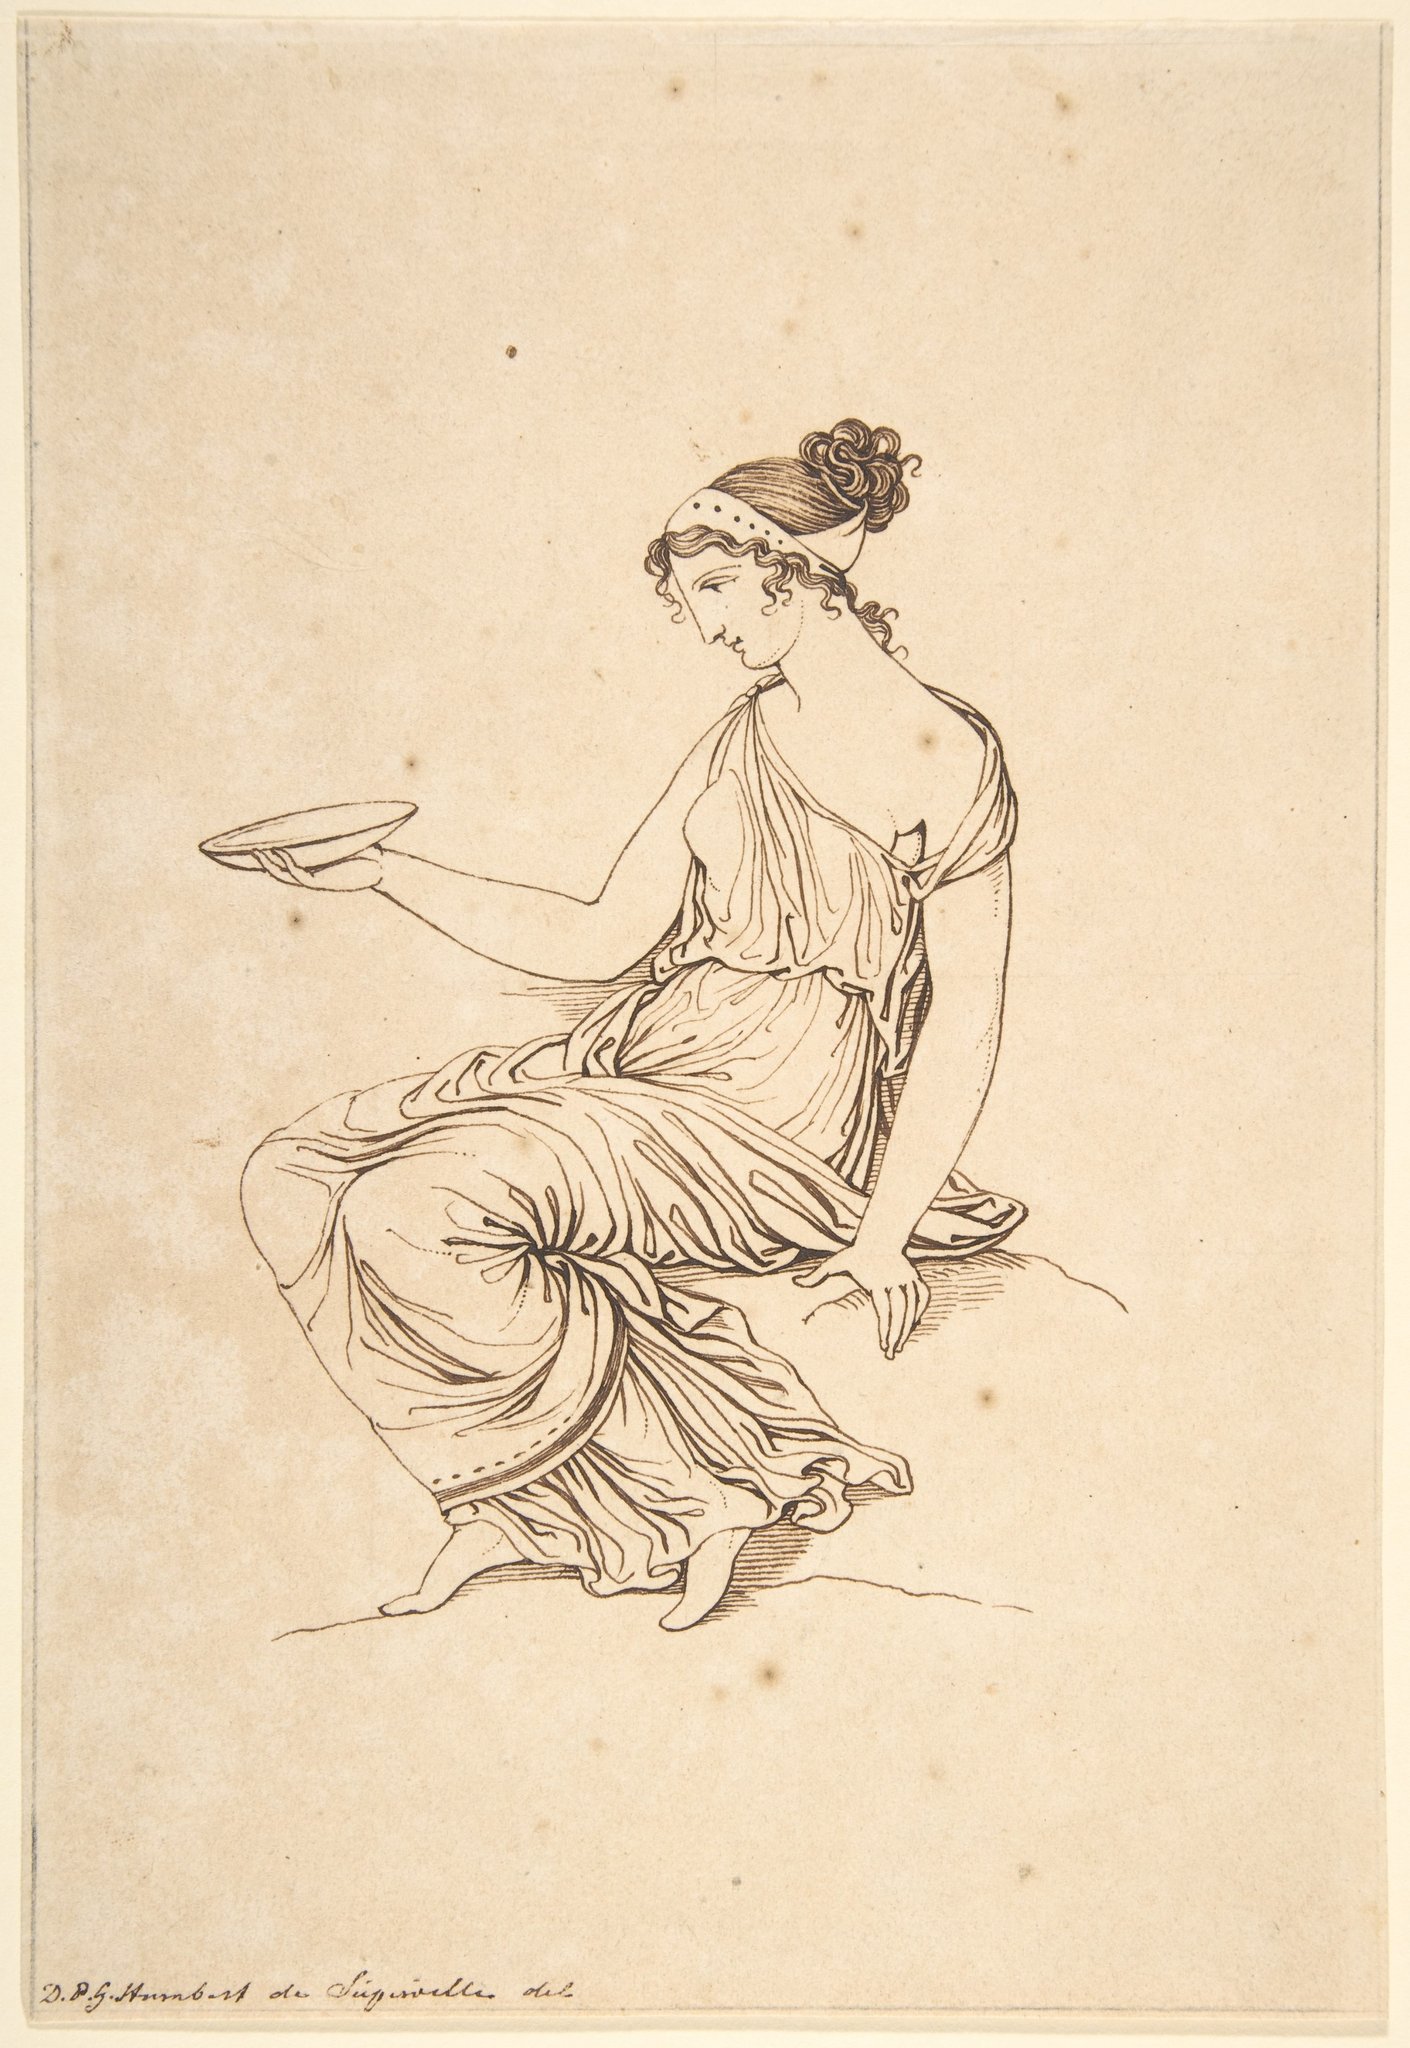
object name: drawing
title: A Seated Woman in Profile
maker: david-pierre giottino humbert de superville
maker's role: artist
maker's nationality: dutch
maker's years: 1770-1849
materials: ink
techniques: pen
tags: profiles,women